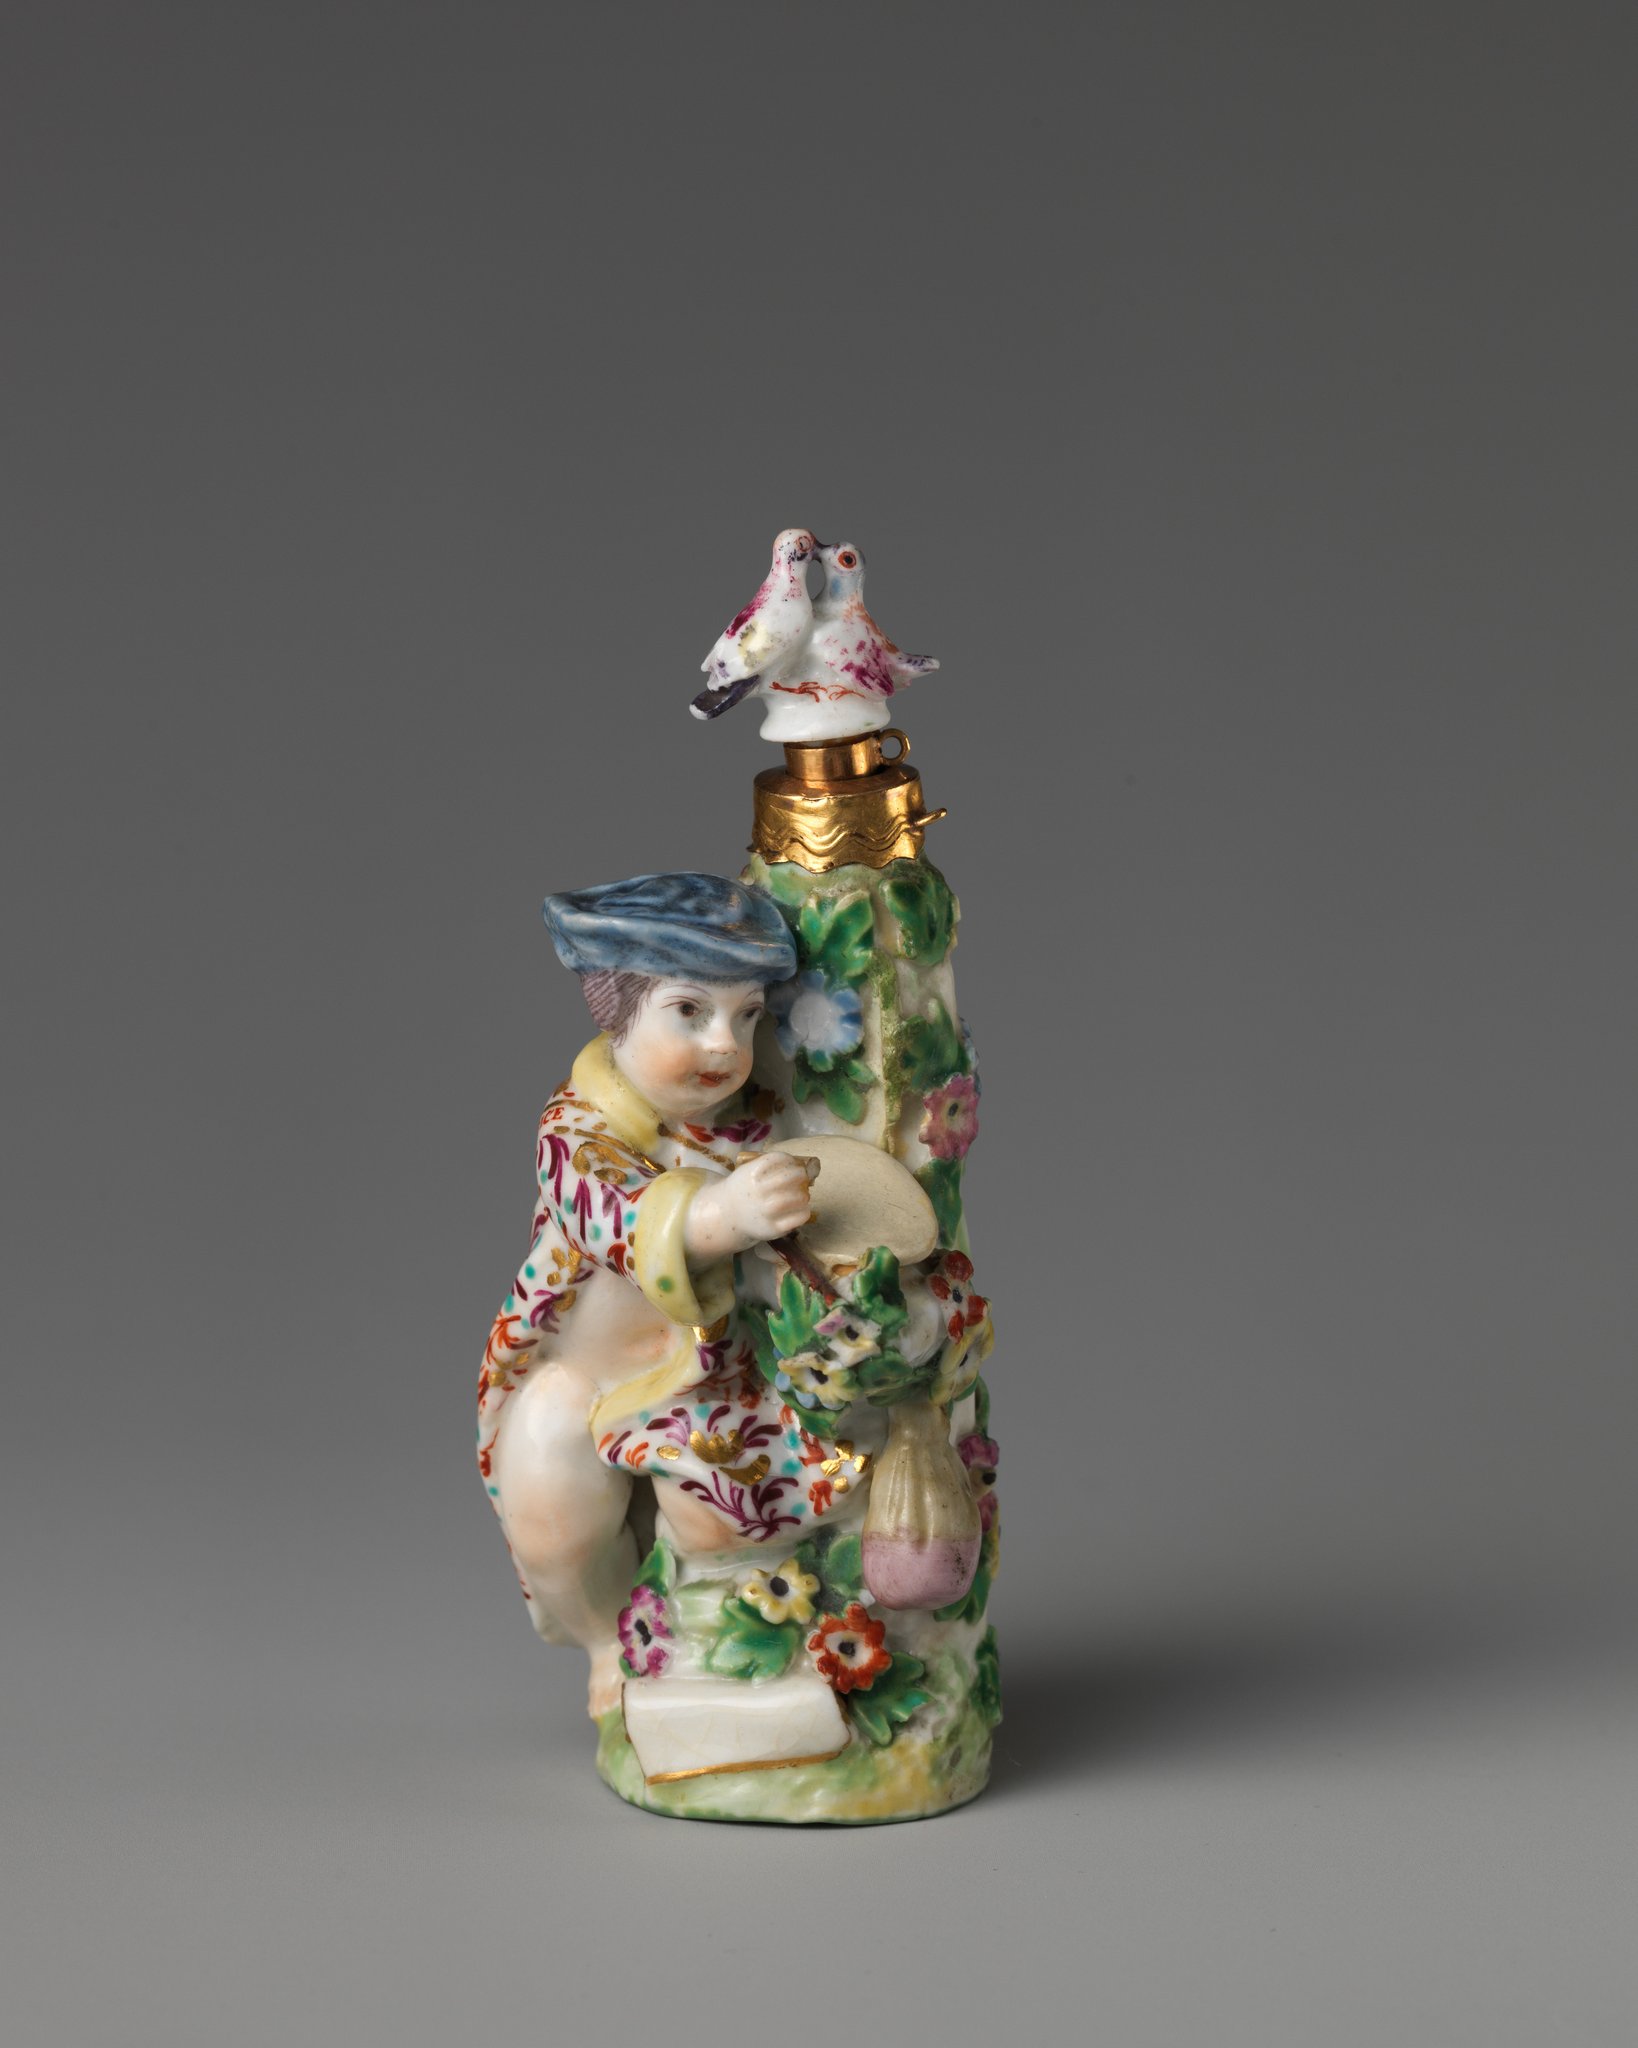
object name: toy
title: Cupid as painter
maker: chelsea porcelain manufactory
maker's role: factory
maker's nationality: british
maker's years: 1744-1784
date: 1765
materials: soft paste porcelain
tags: birds,cupid,flowers,leaves